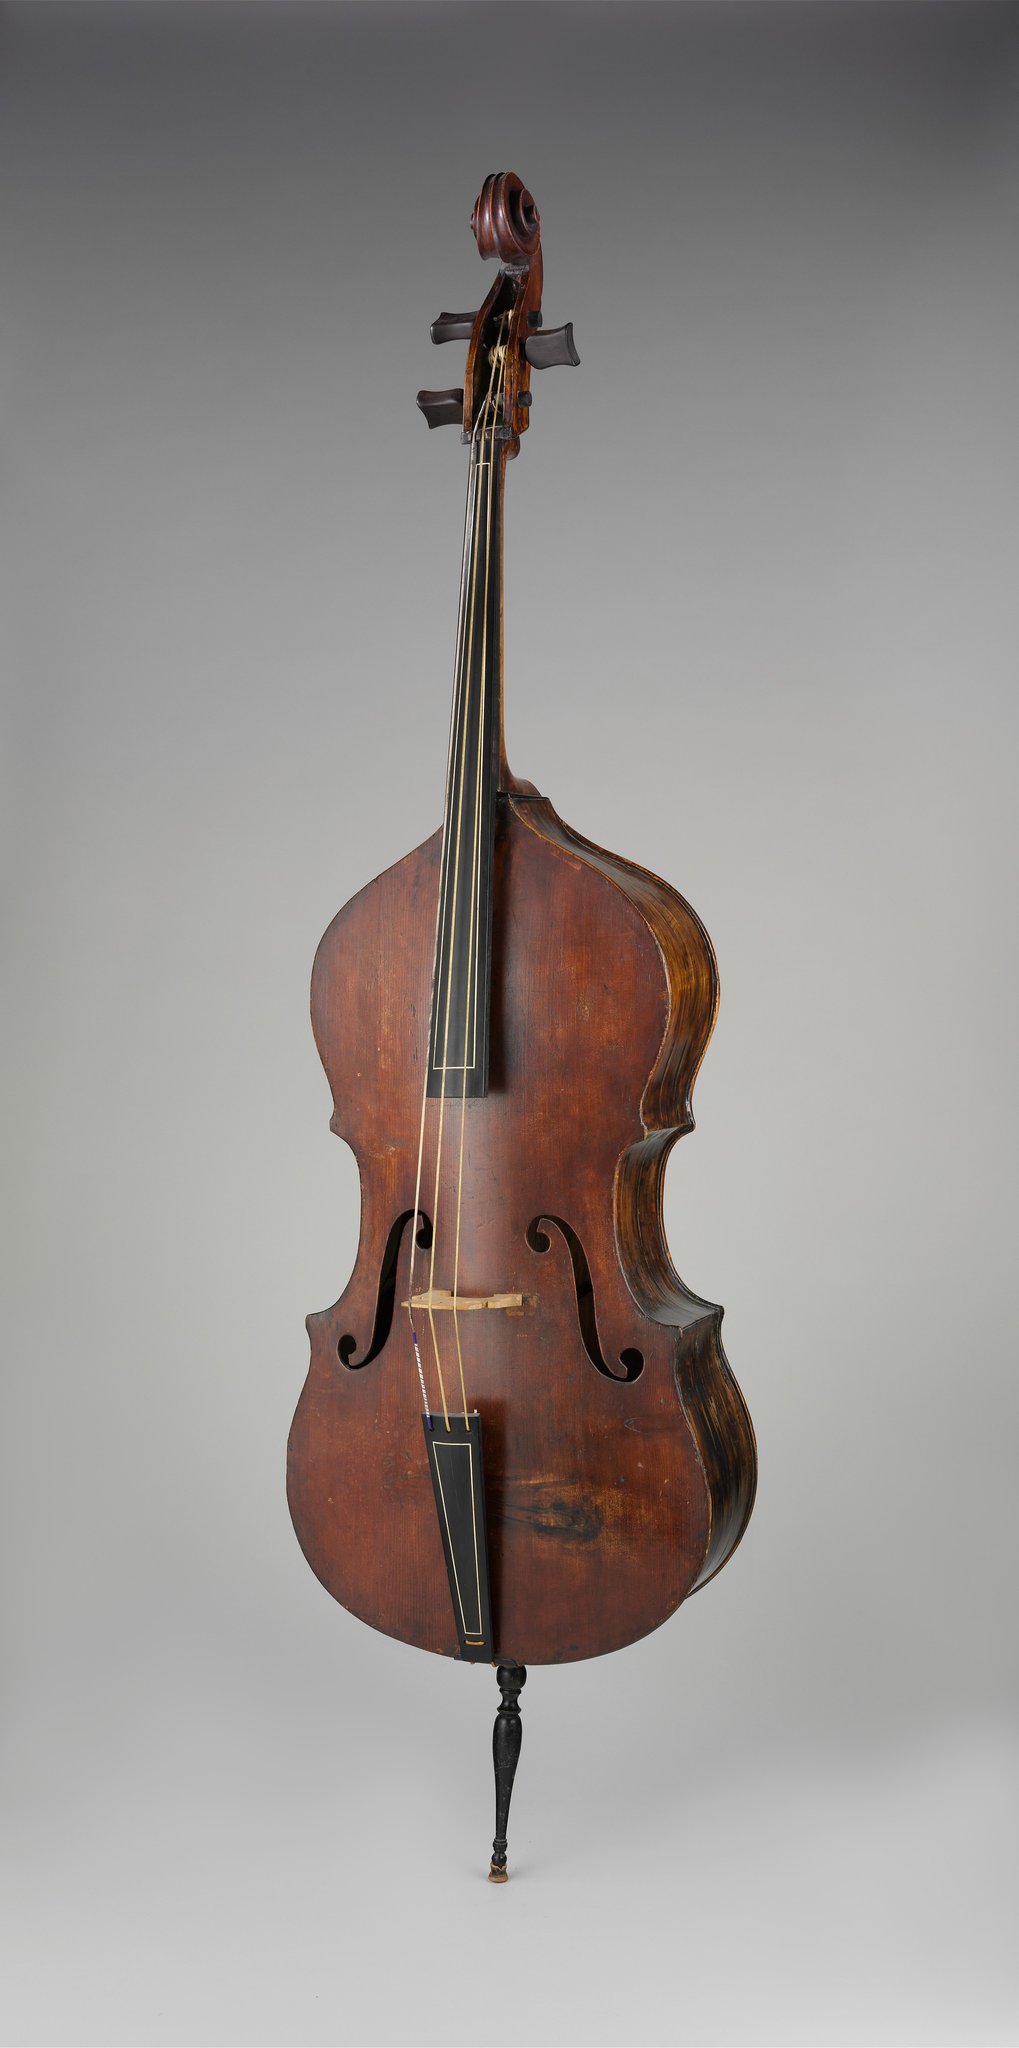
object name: double bass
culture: italian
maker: bartolomeo cristofori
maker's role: former attribution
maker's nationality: italian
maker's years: 1655-1731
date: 1701-1800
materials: wood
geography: italy